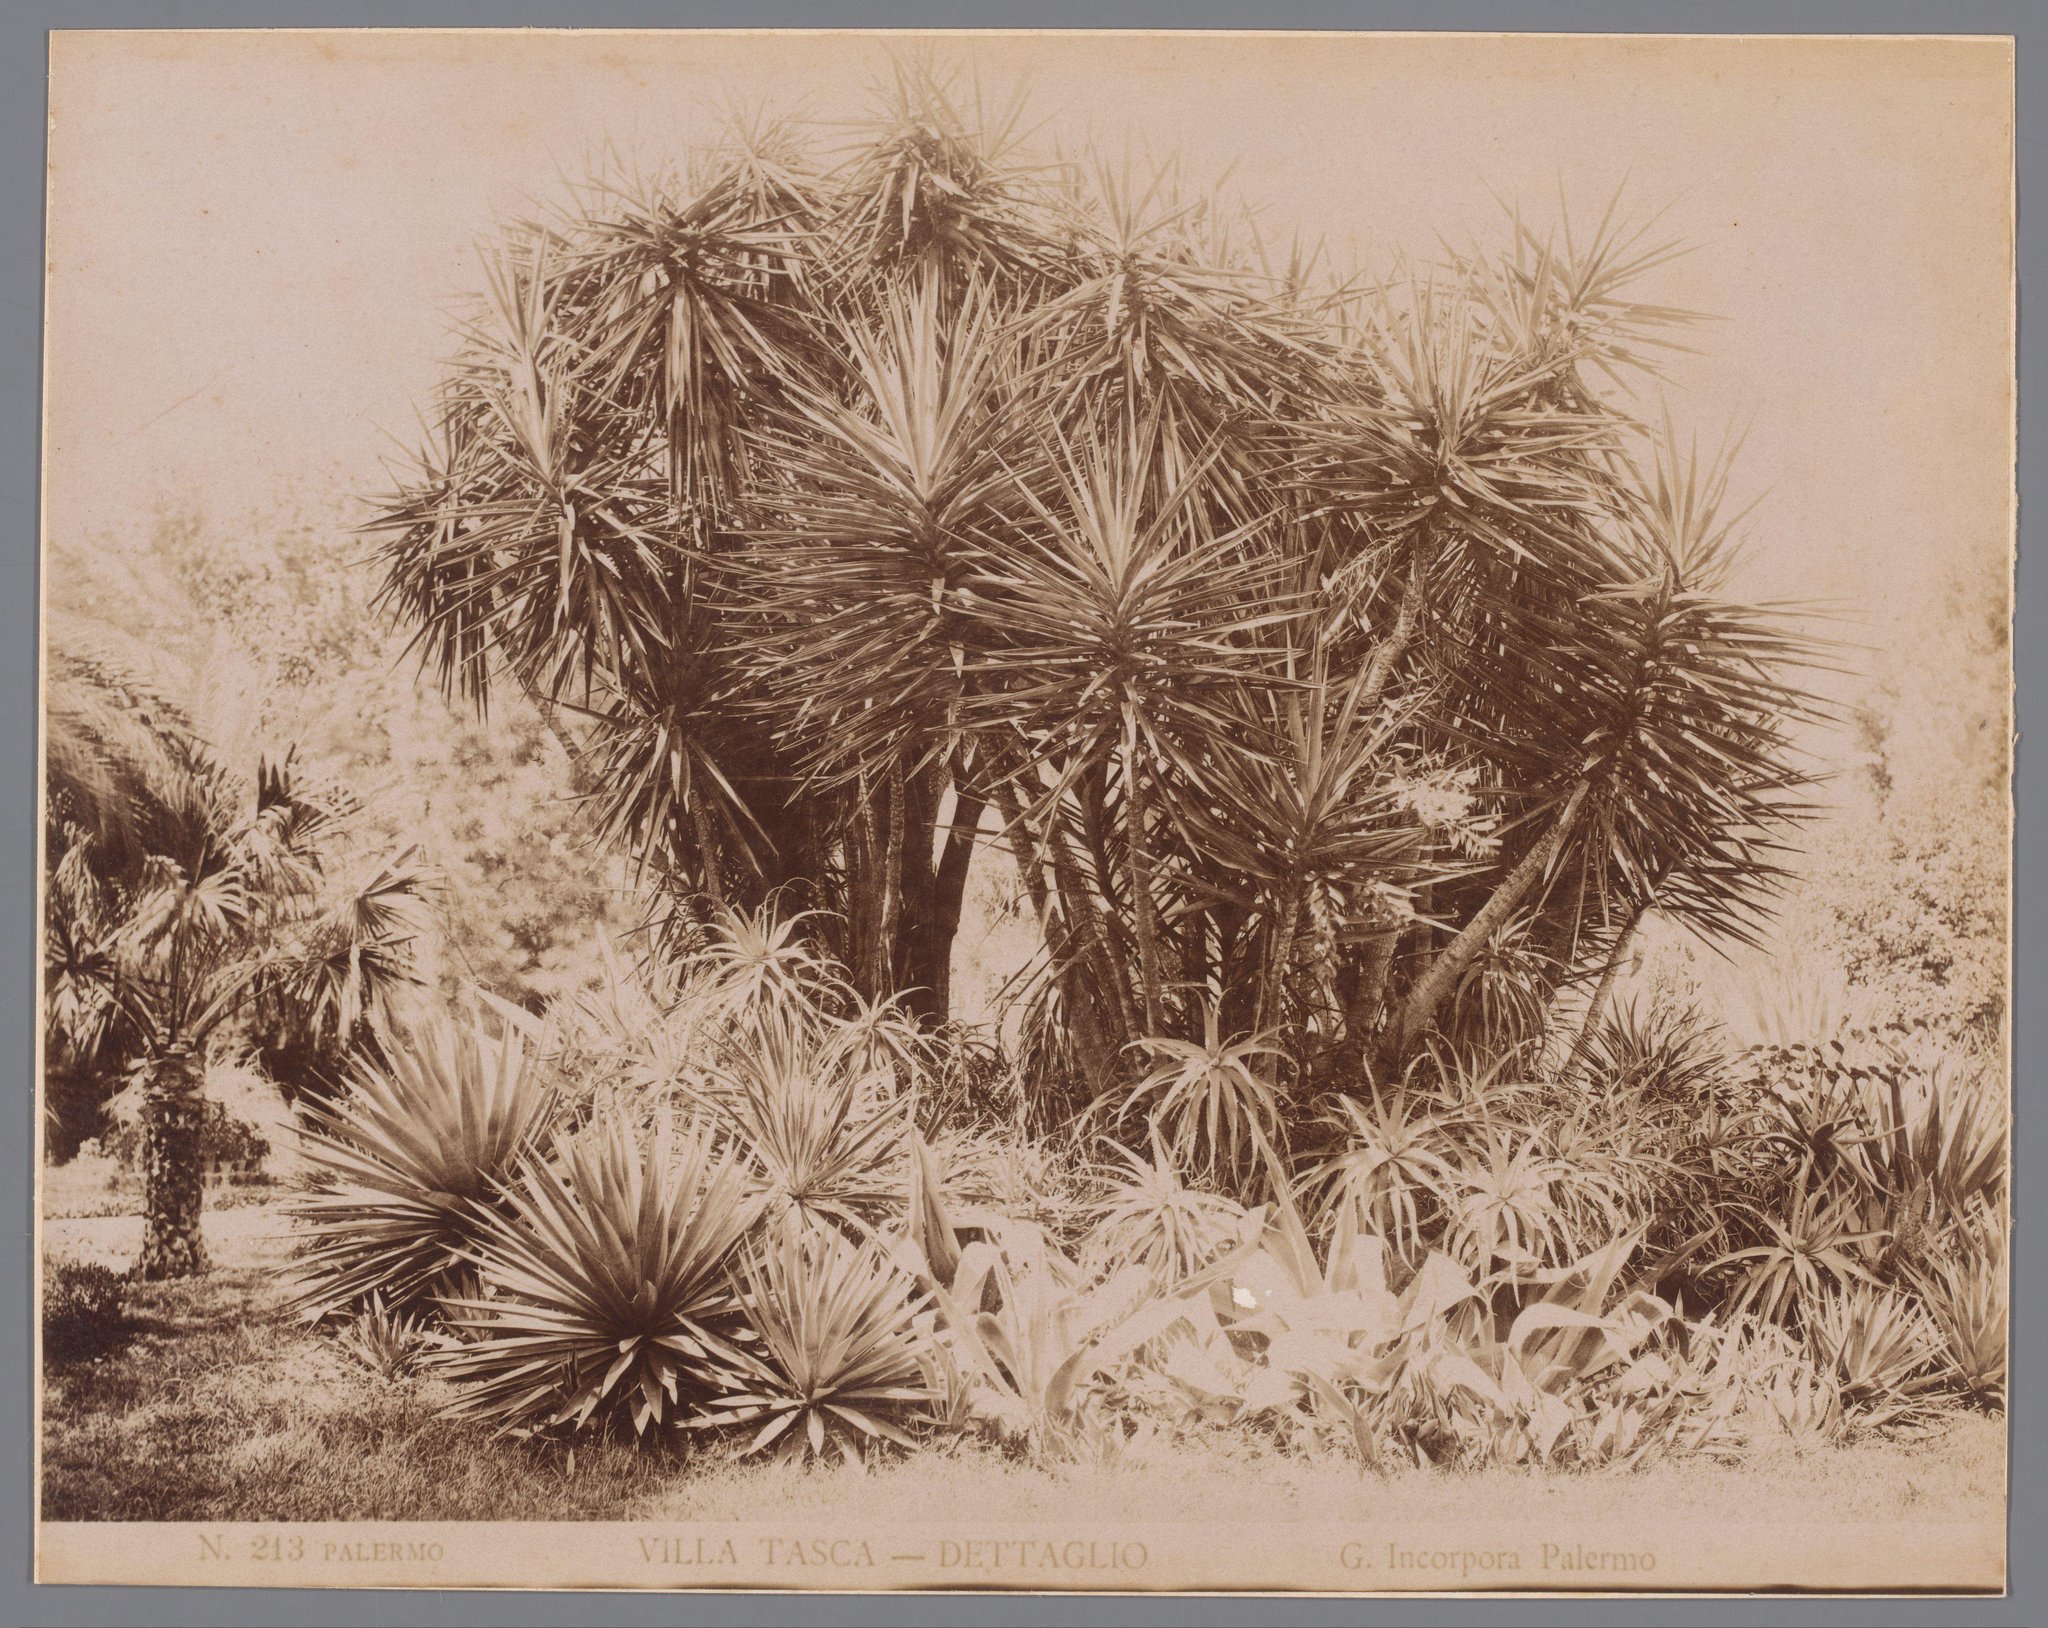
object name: photograph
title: Villa Tasca, dettaglio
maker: giuseppe incorpora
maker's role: fotograaf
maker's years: 1834-1914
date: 1856-1914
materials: paper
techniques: albumen print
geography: palermo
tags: garden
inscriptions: number: ‘N. 213’